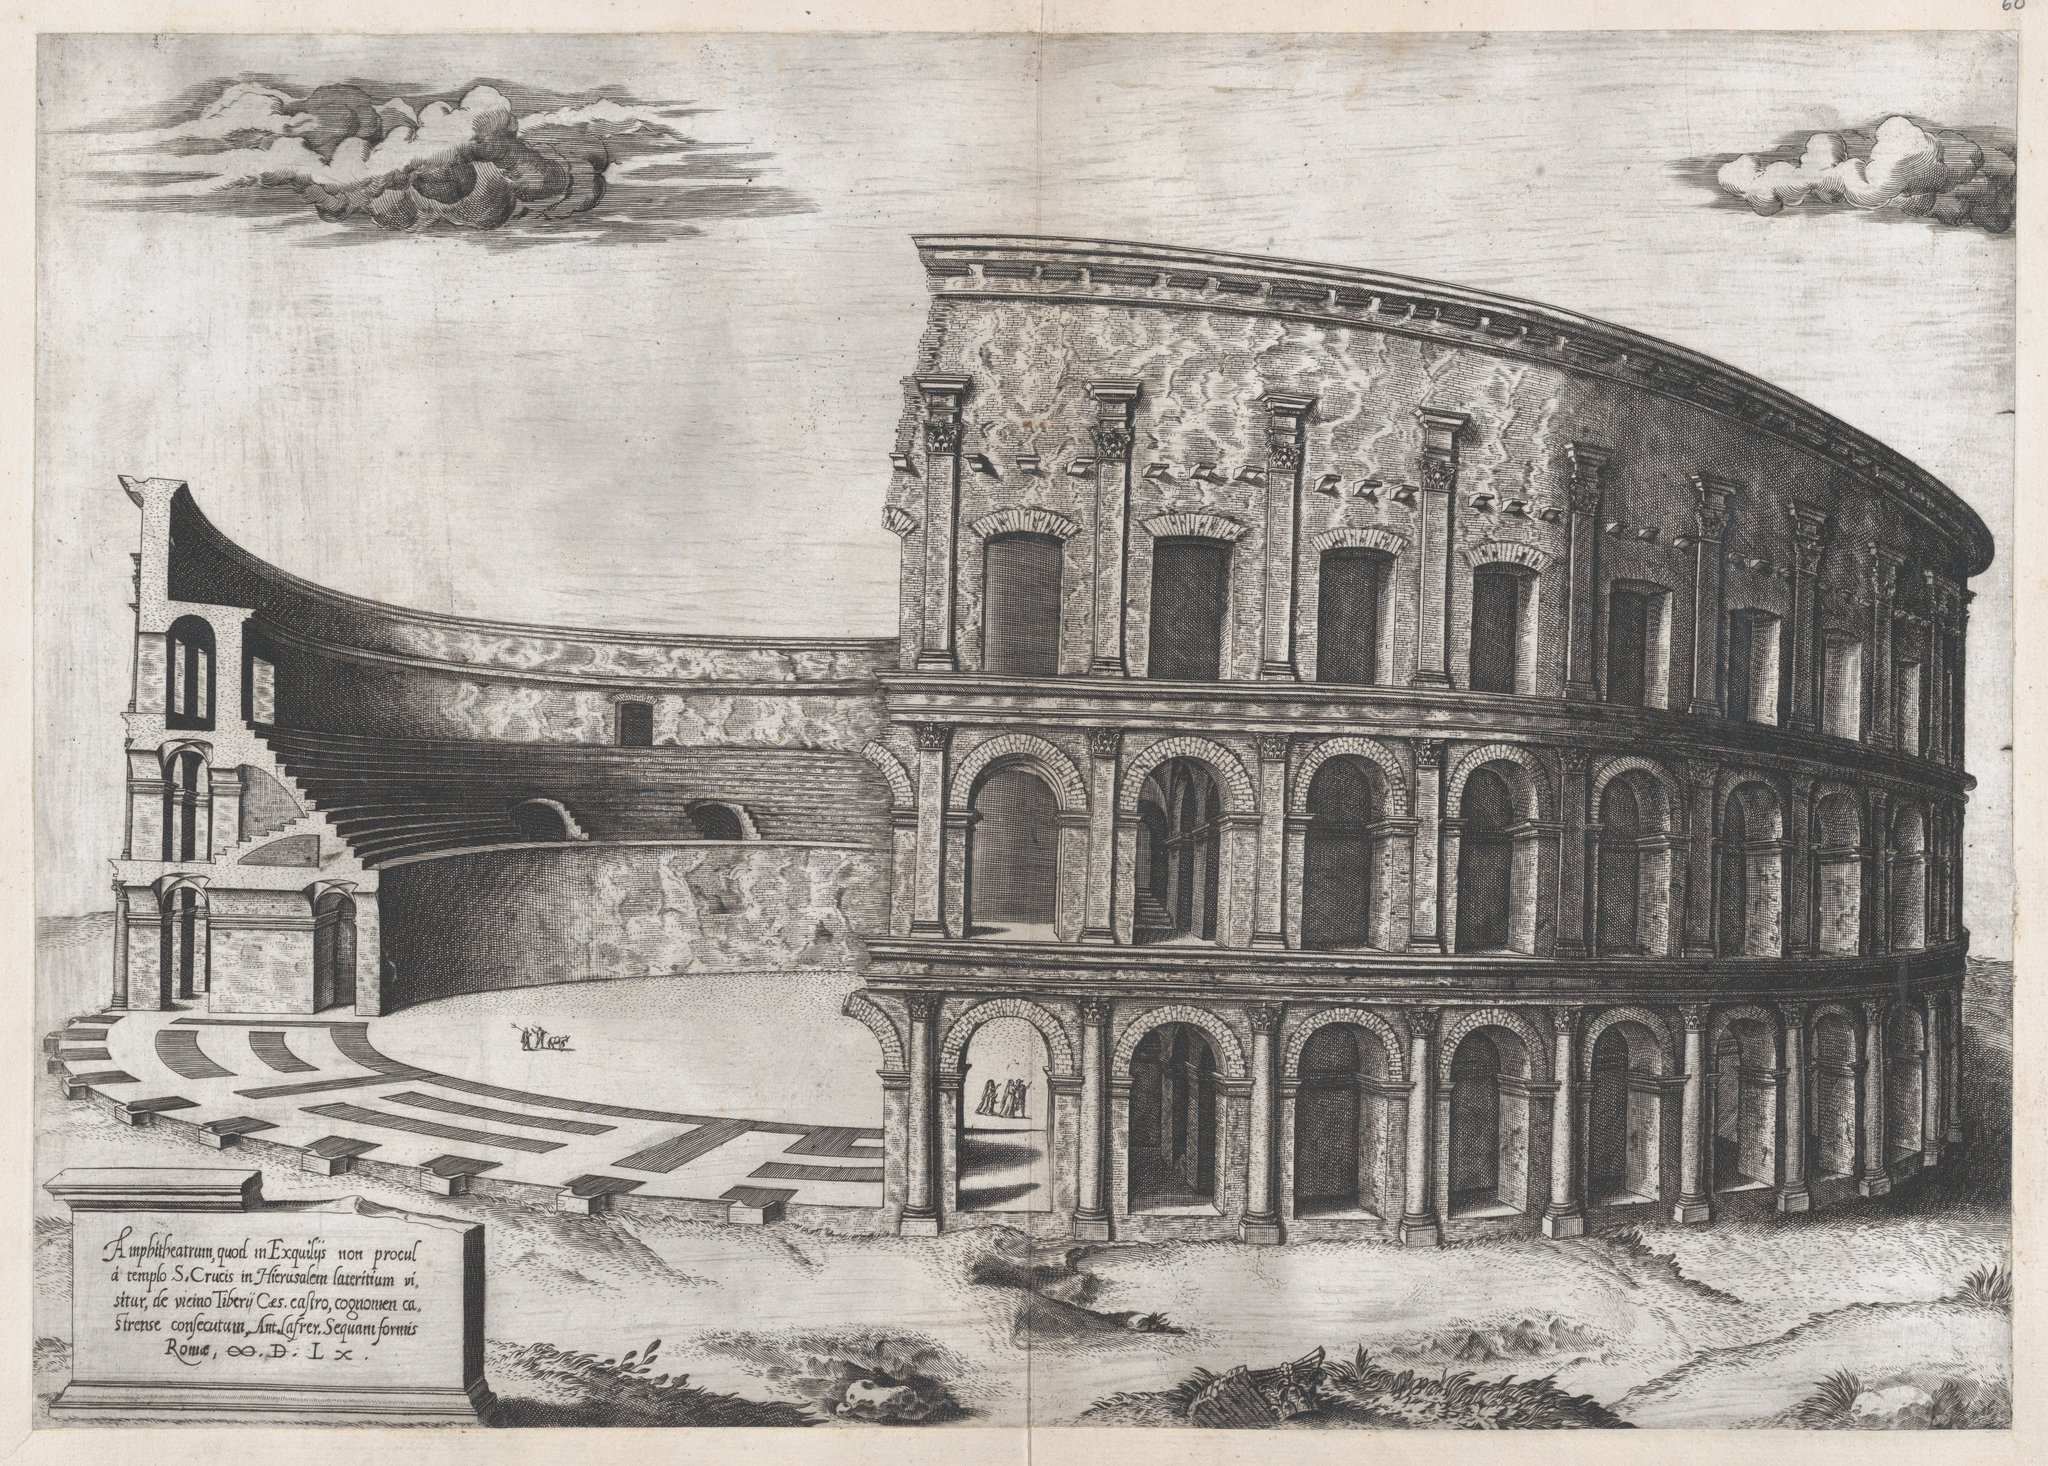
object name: print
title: Amphiteathrum Castrense, from "Speculum Romanae Magnificentiae"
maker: Anonymous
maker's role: artist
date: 1560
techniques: engraving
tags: architecture,rome